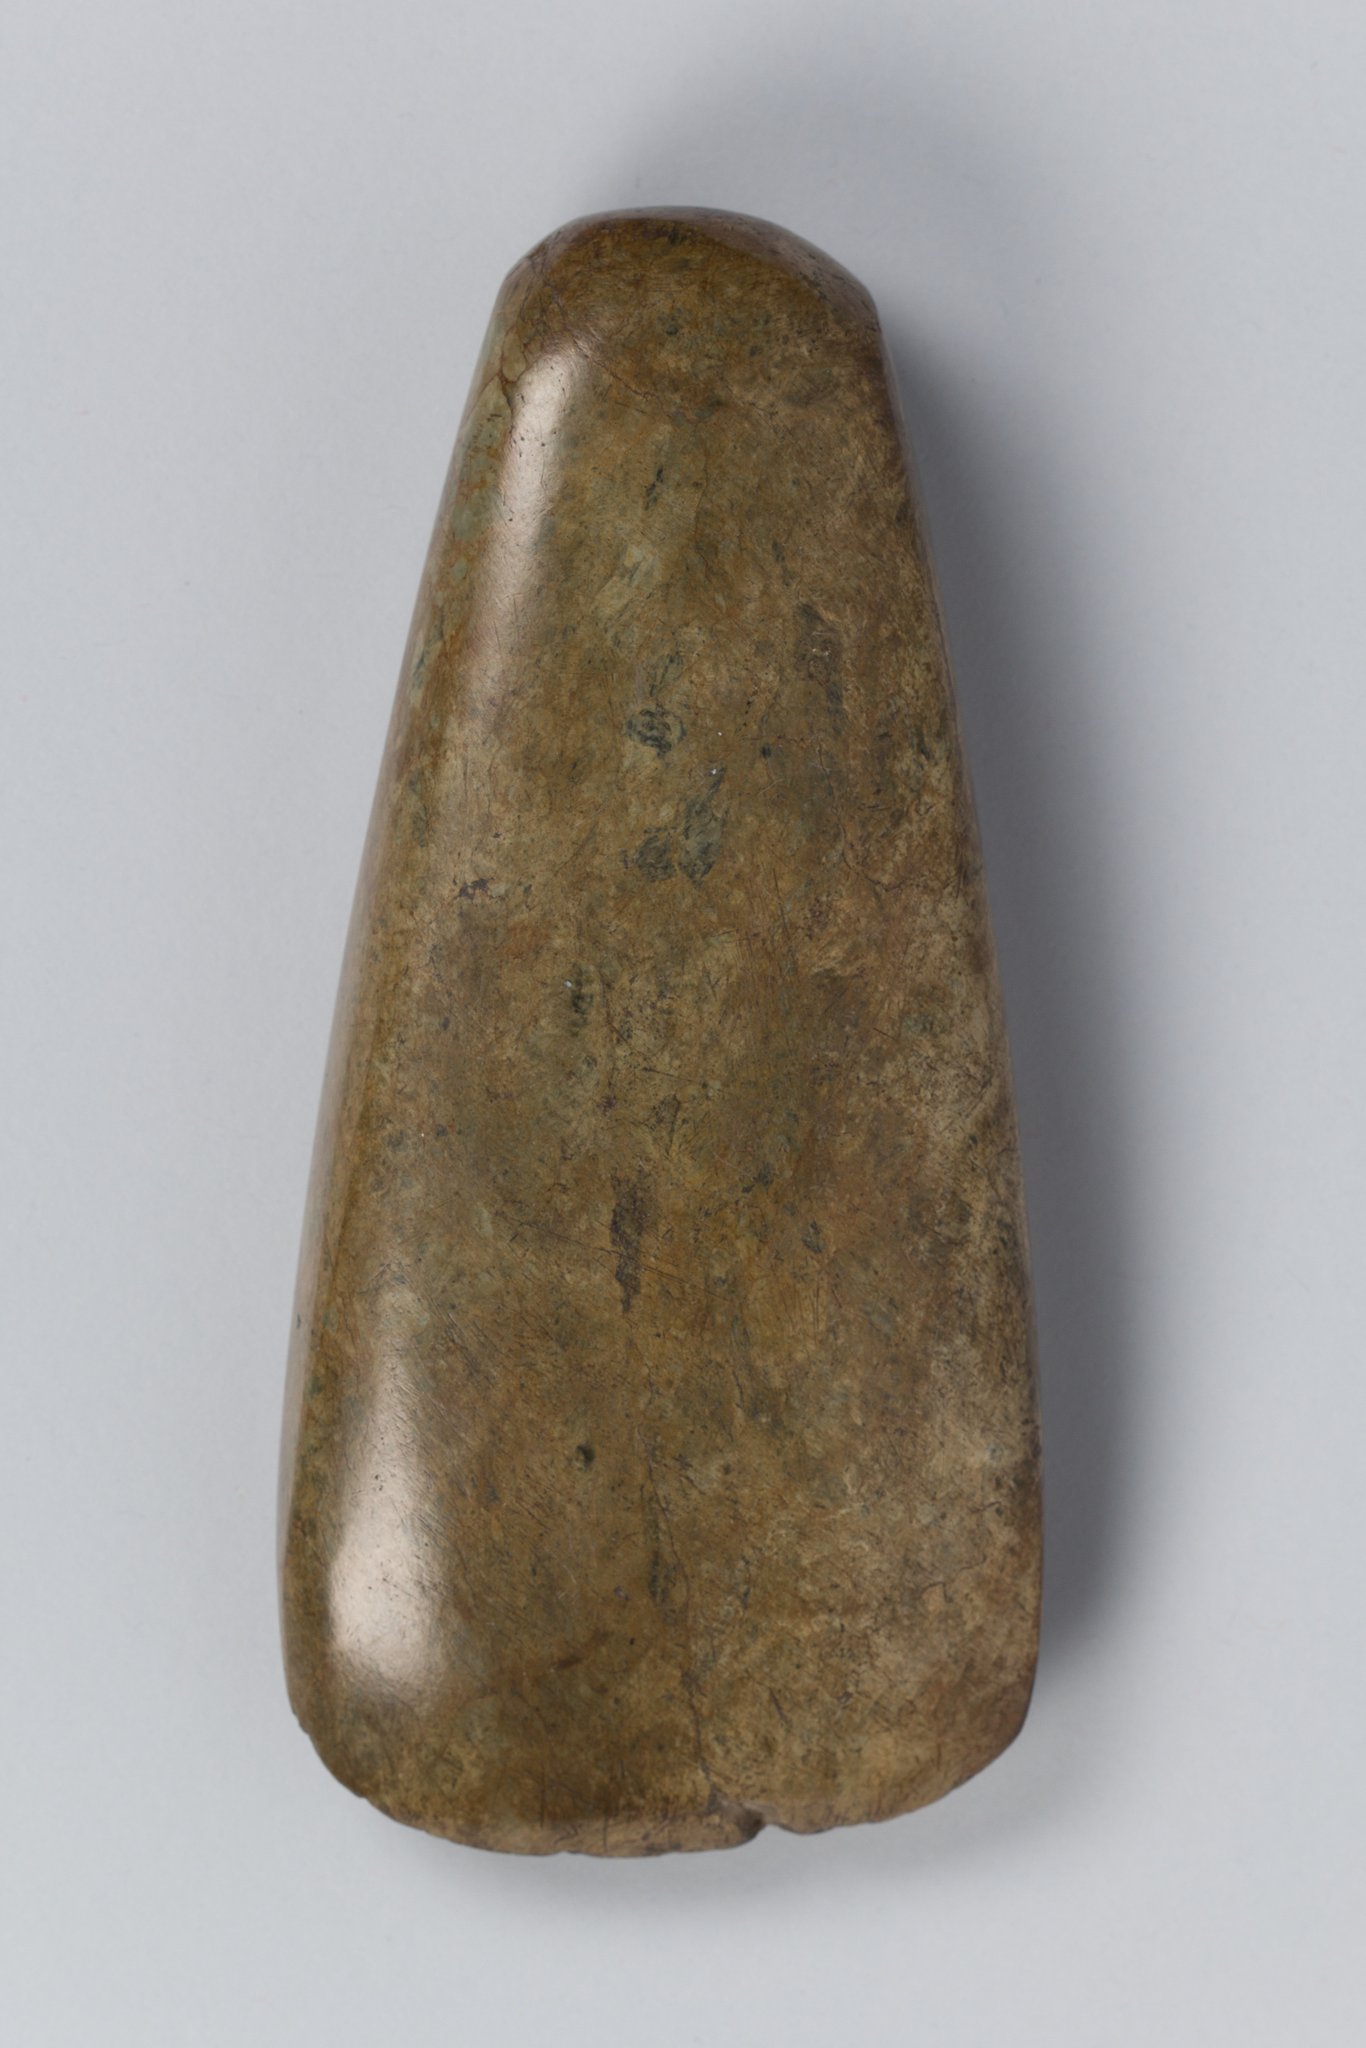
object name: axe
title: Polished Stone Axe (Masei sekifu)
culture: japanese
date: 1500-1000 BCE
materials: stone